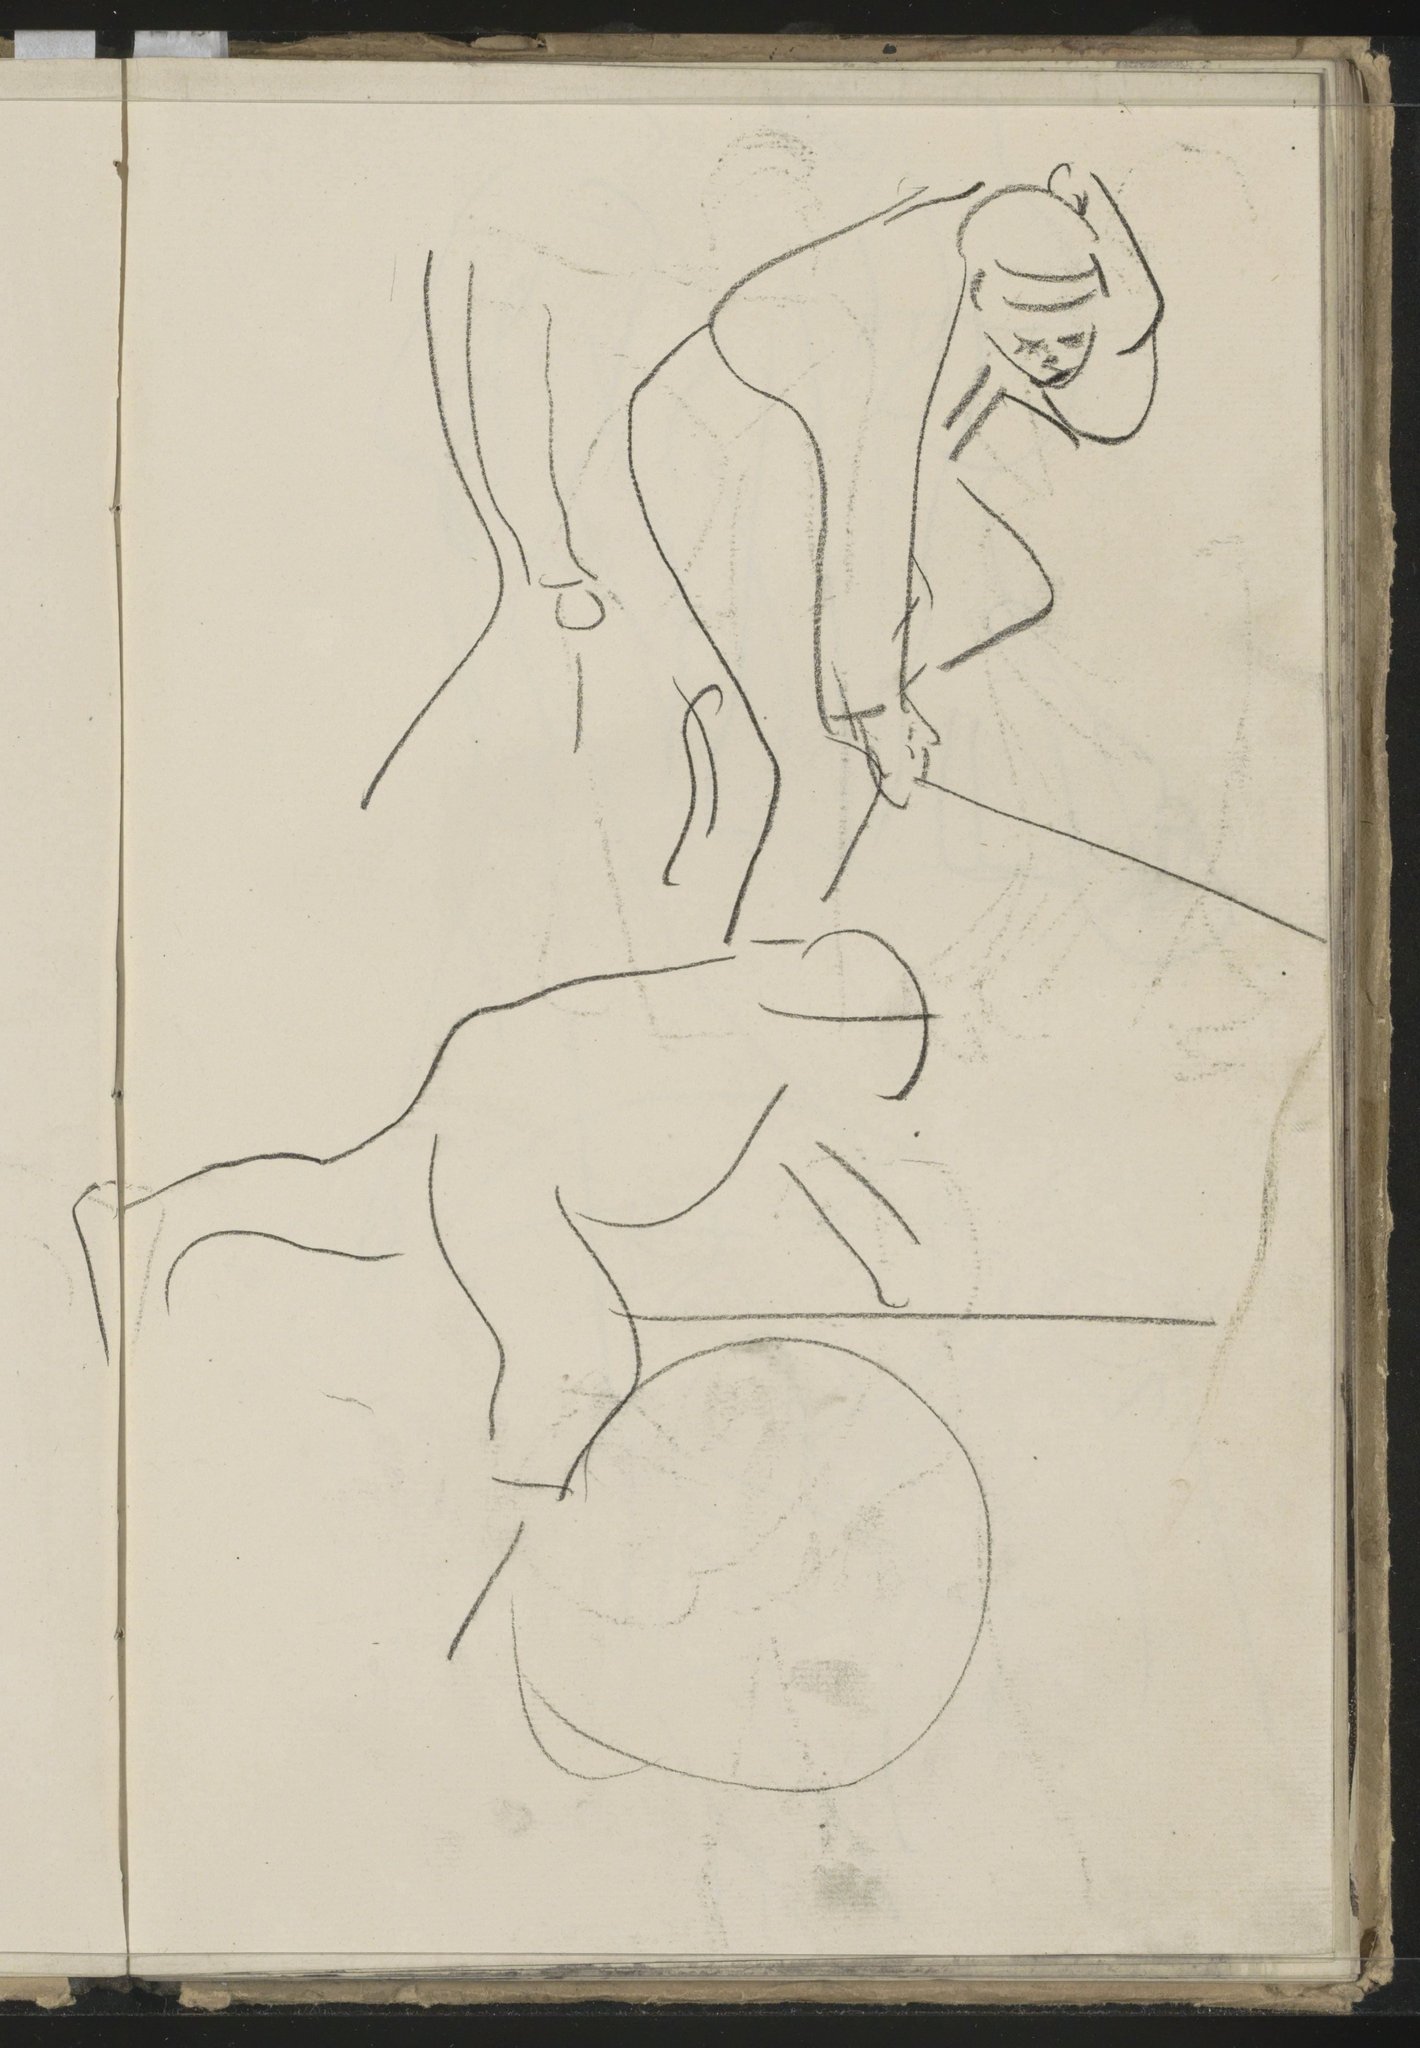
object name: sketchbook leaf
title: Bukkende figuren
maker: carel adolph lion cachet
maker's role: draughtsman, print maker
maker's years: 1864-1945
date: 1890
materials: chalk, paper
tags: bending figure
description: Blad 7 recto uit een schetsboek met 38 bladen.